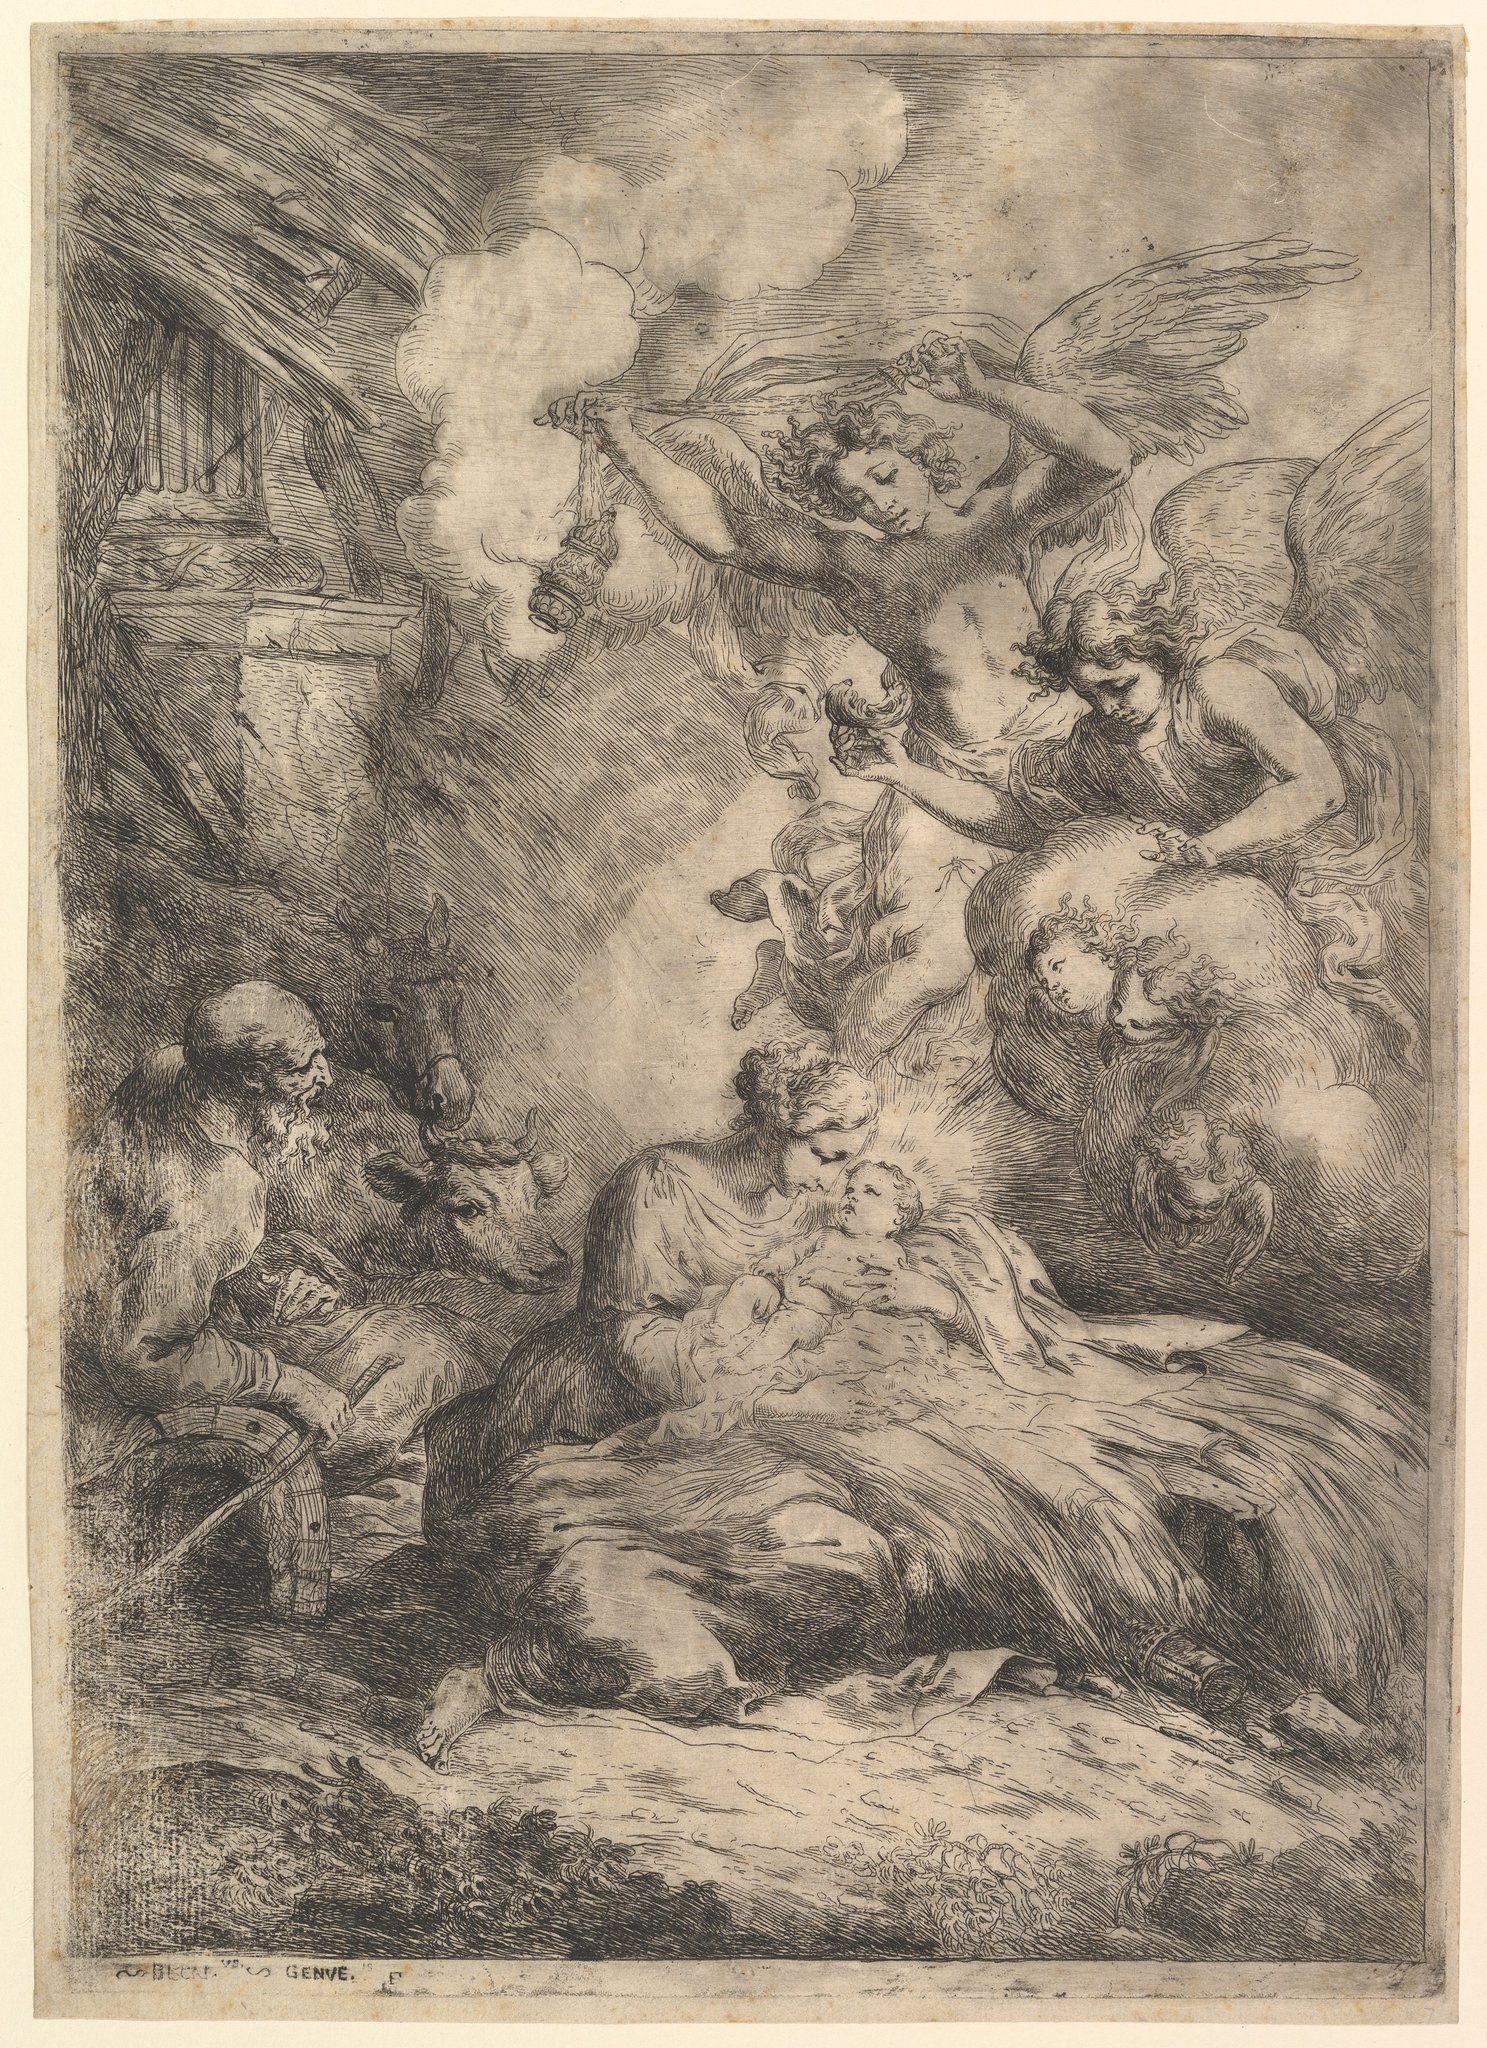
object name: print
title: The Nativity with Angels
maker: bartolomeo biscaino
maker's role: artist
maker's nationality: italian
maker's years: 1632-1657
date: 1650-1657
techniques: etching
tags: angels,madonna and child,nativity